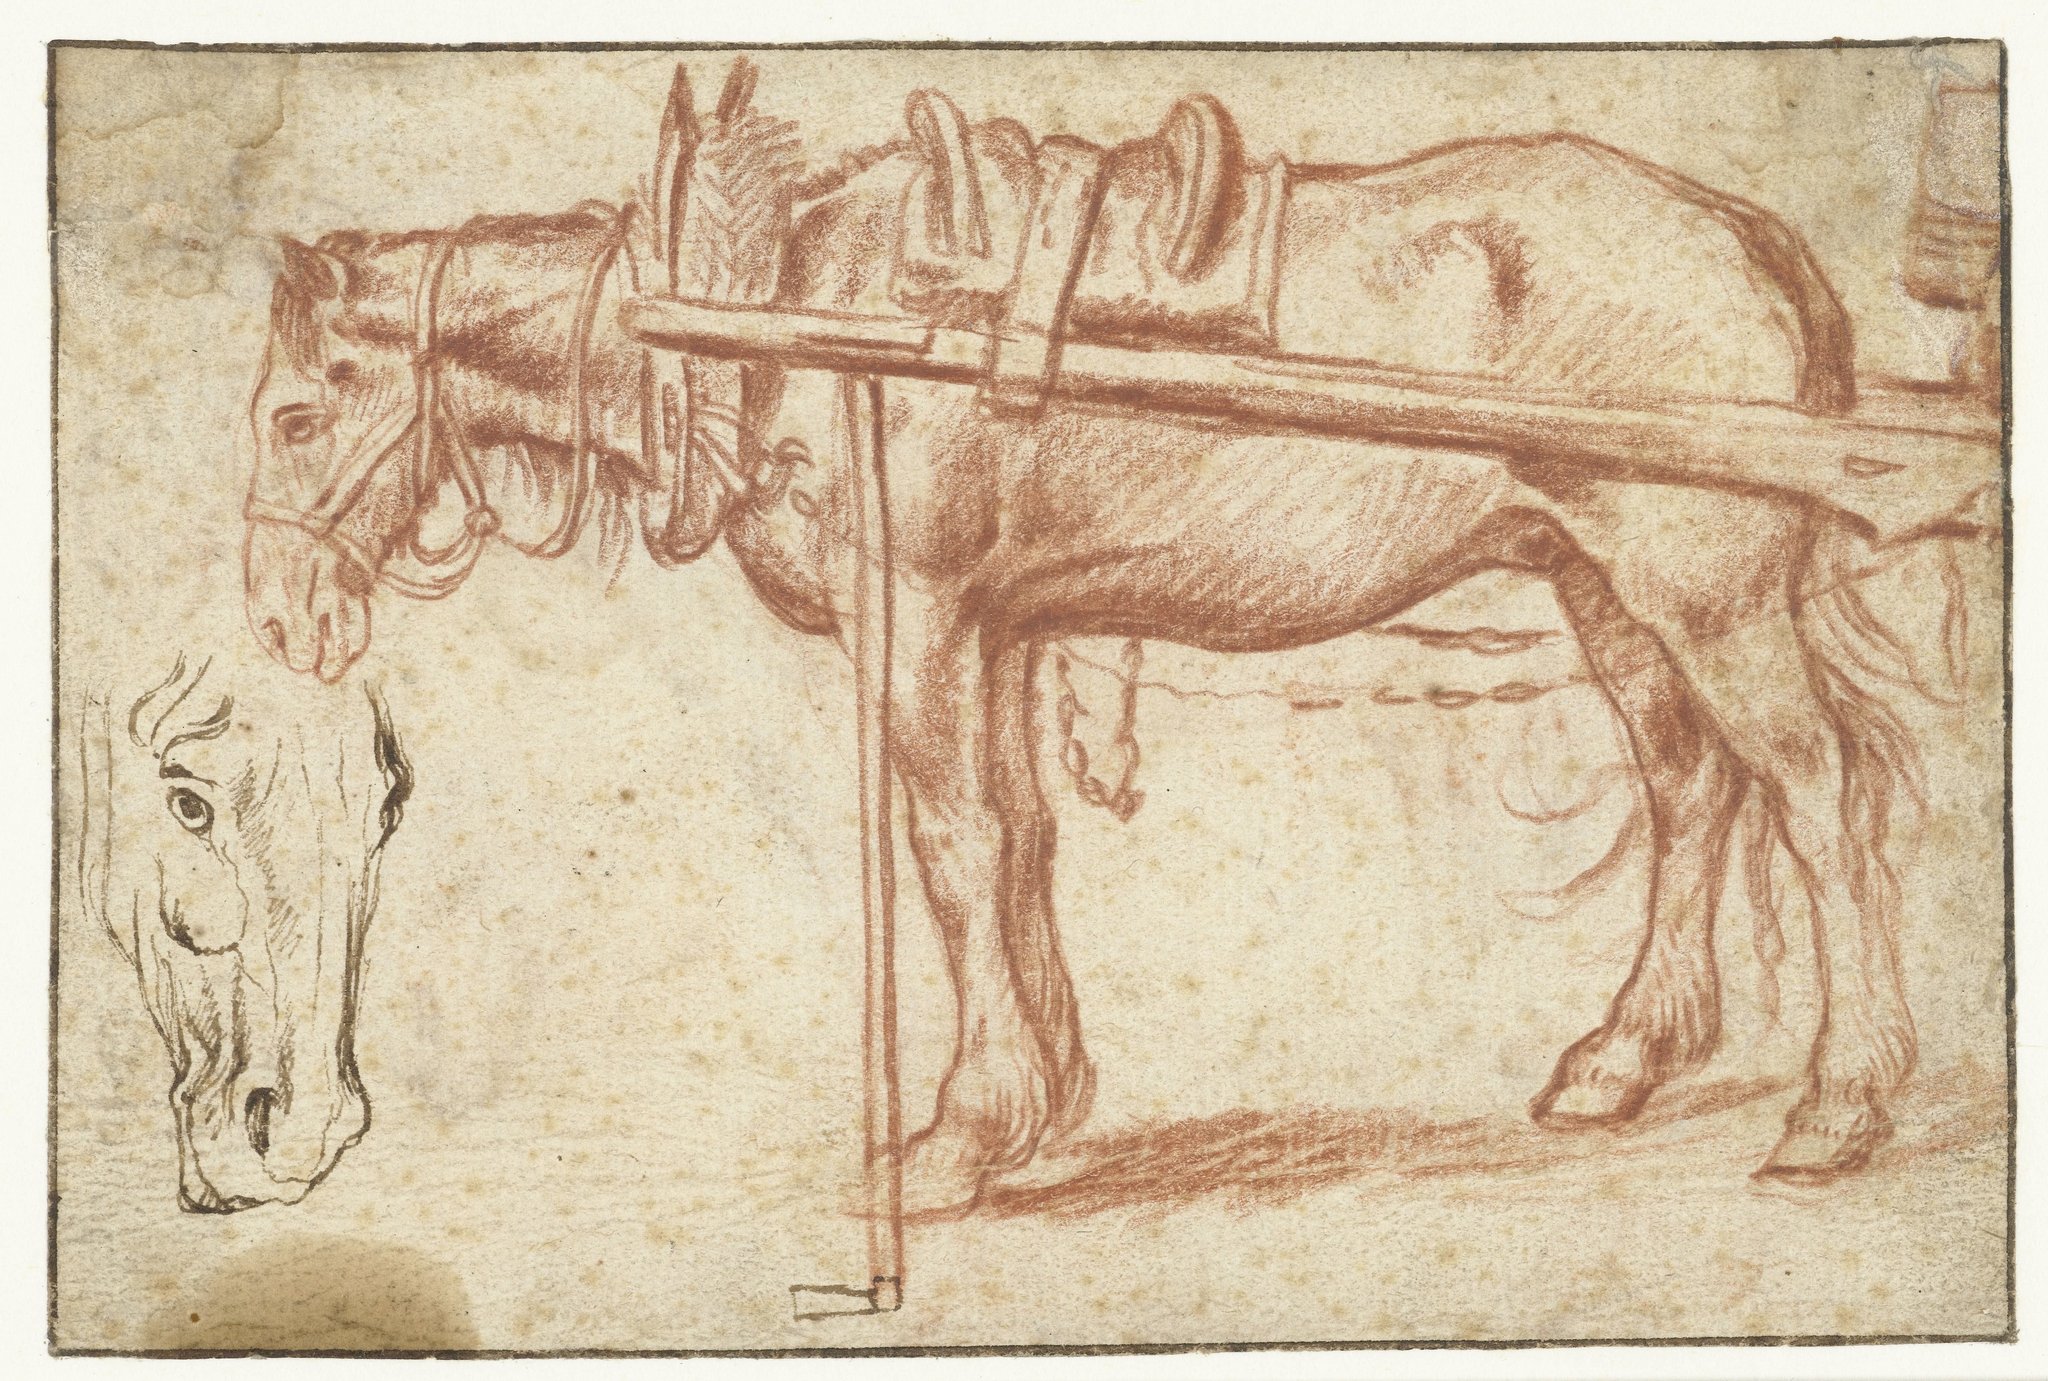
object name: drawing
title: Paard voor een kar en een paardenhoofd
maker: jan brueghel (i)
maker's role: draughtsman, painter, print maker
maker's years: 1568-1625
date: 1578-1625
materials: chalk, ink, paper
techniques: pen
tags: horse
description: Paard voor een kar, naar links, en schets van een paardenhoofd.